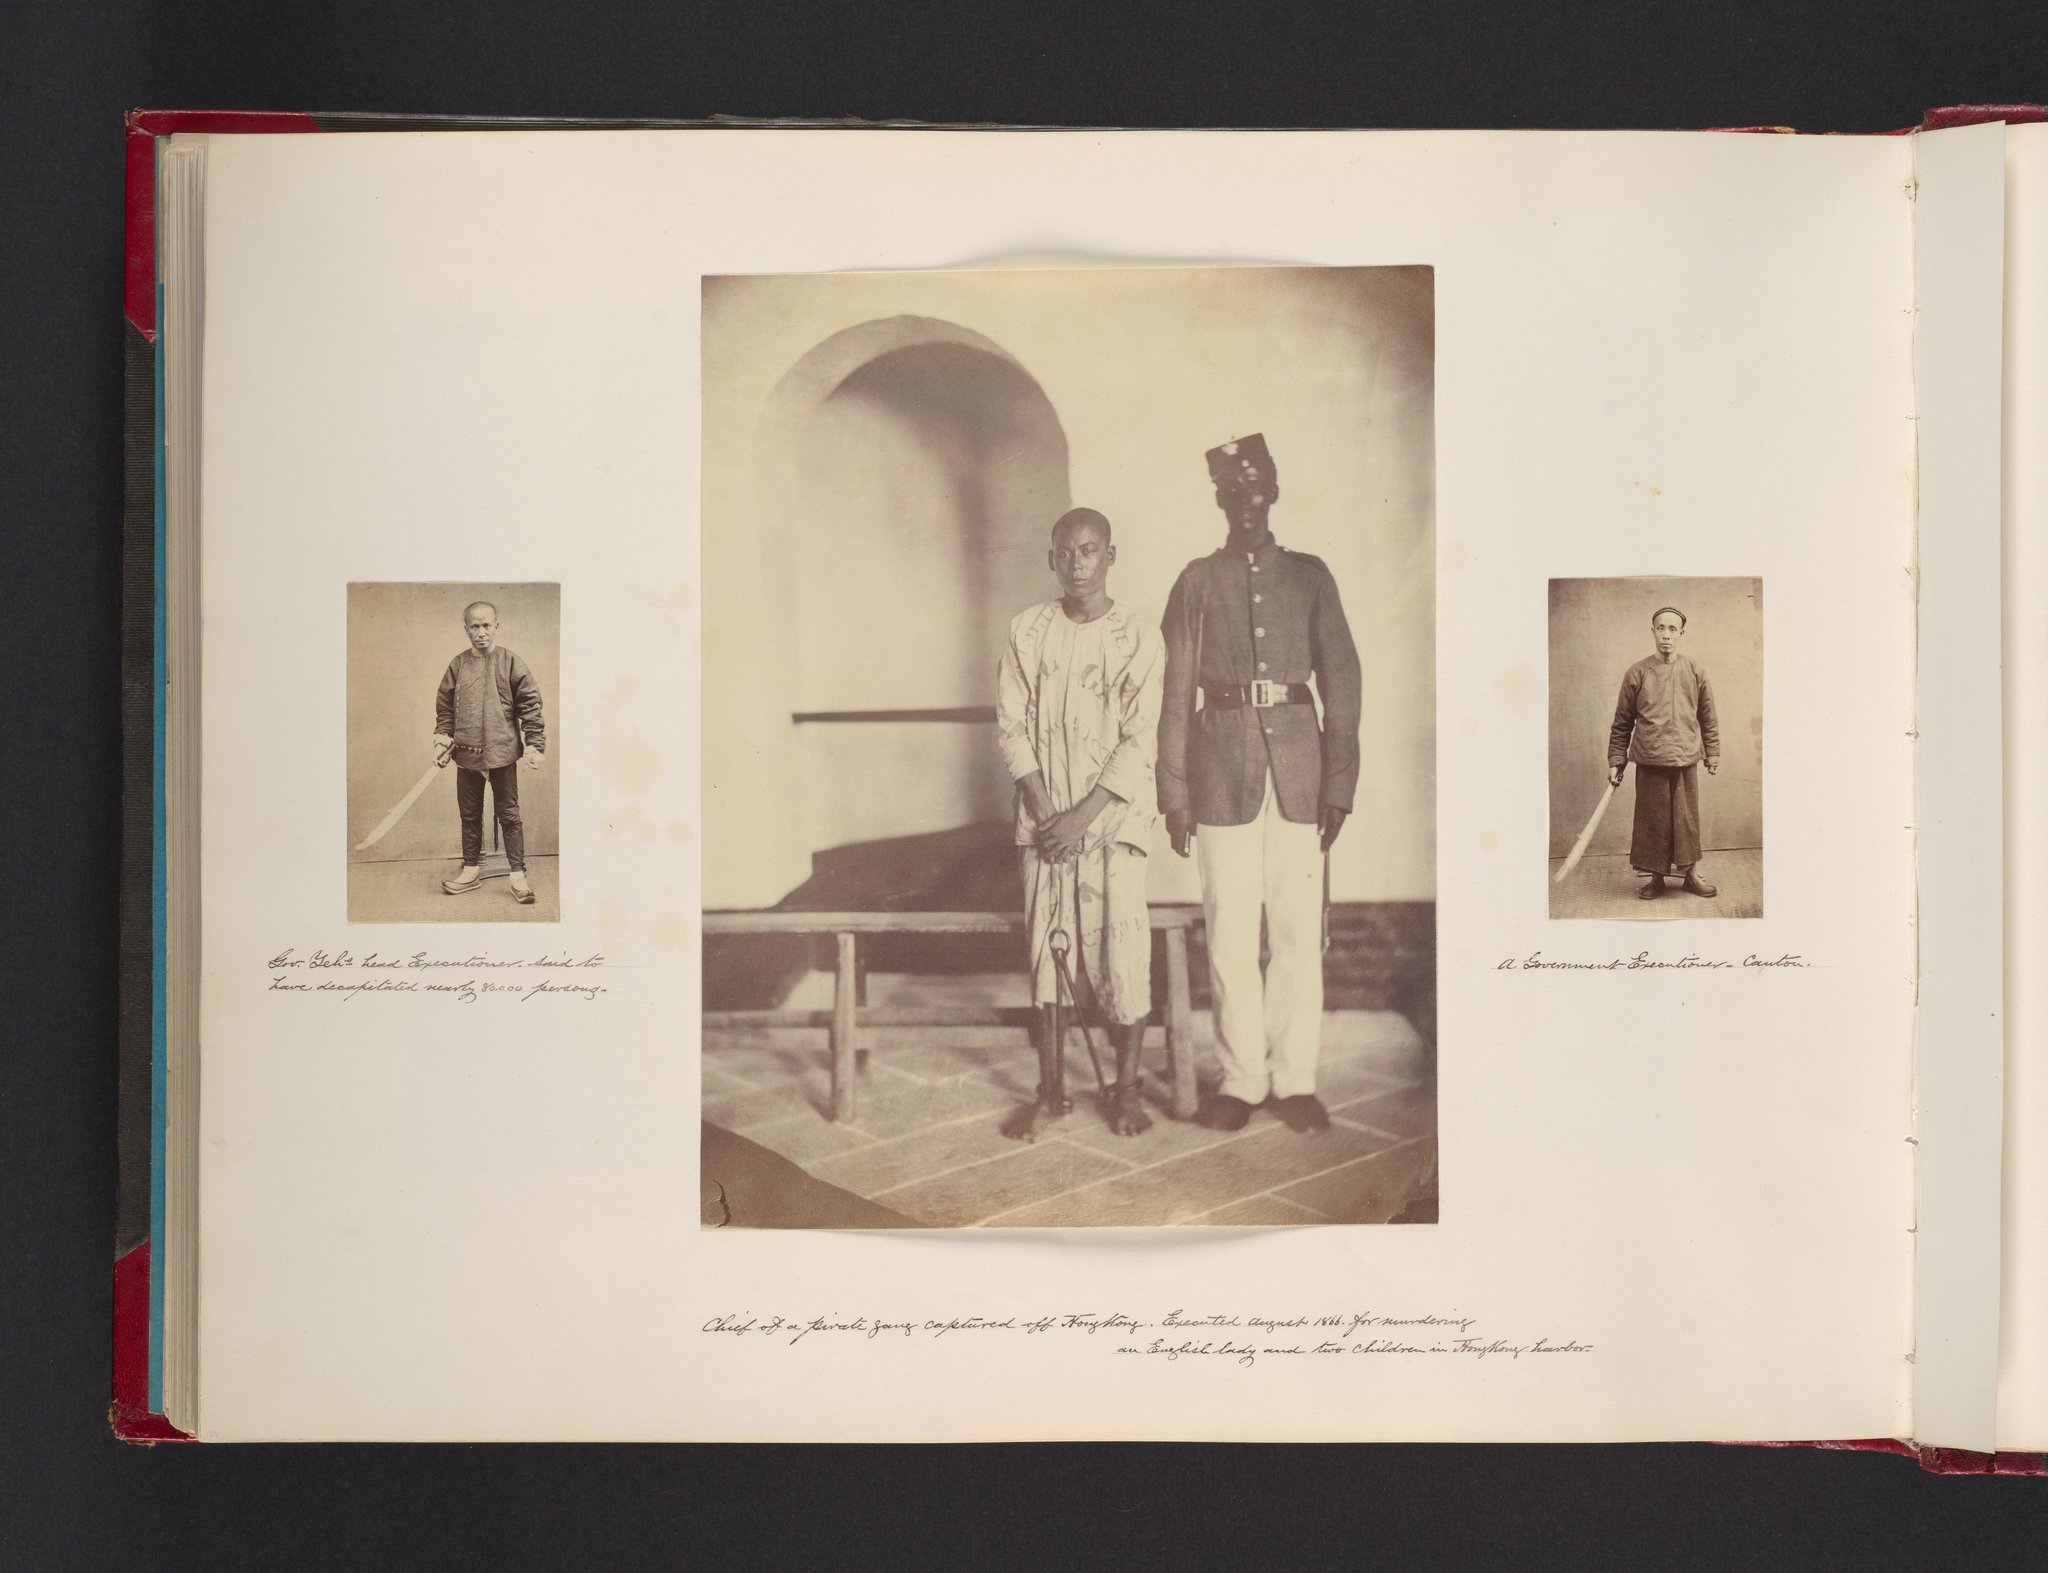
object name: photograph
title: Head Executioner; Chief of Private Gang Capturefd Off Hong Kong; A Government Executioner, Canton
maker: john thomson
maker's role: artist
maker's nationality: british, scottish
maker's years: 1837-1921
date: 1866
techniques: albumen silver print, glass negative